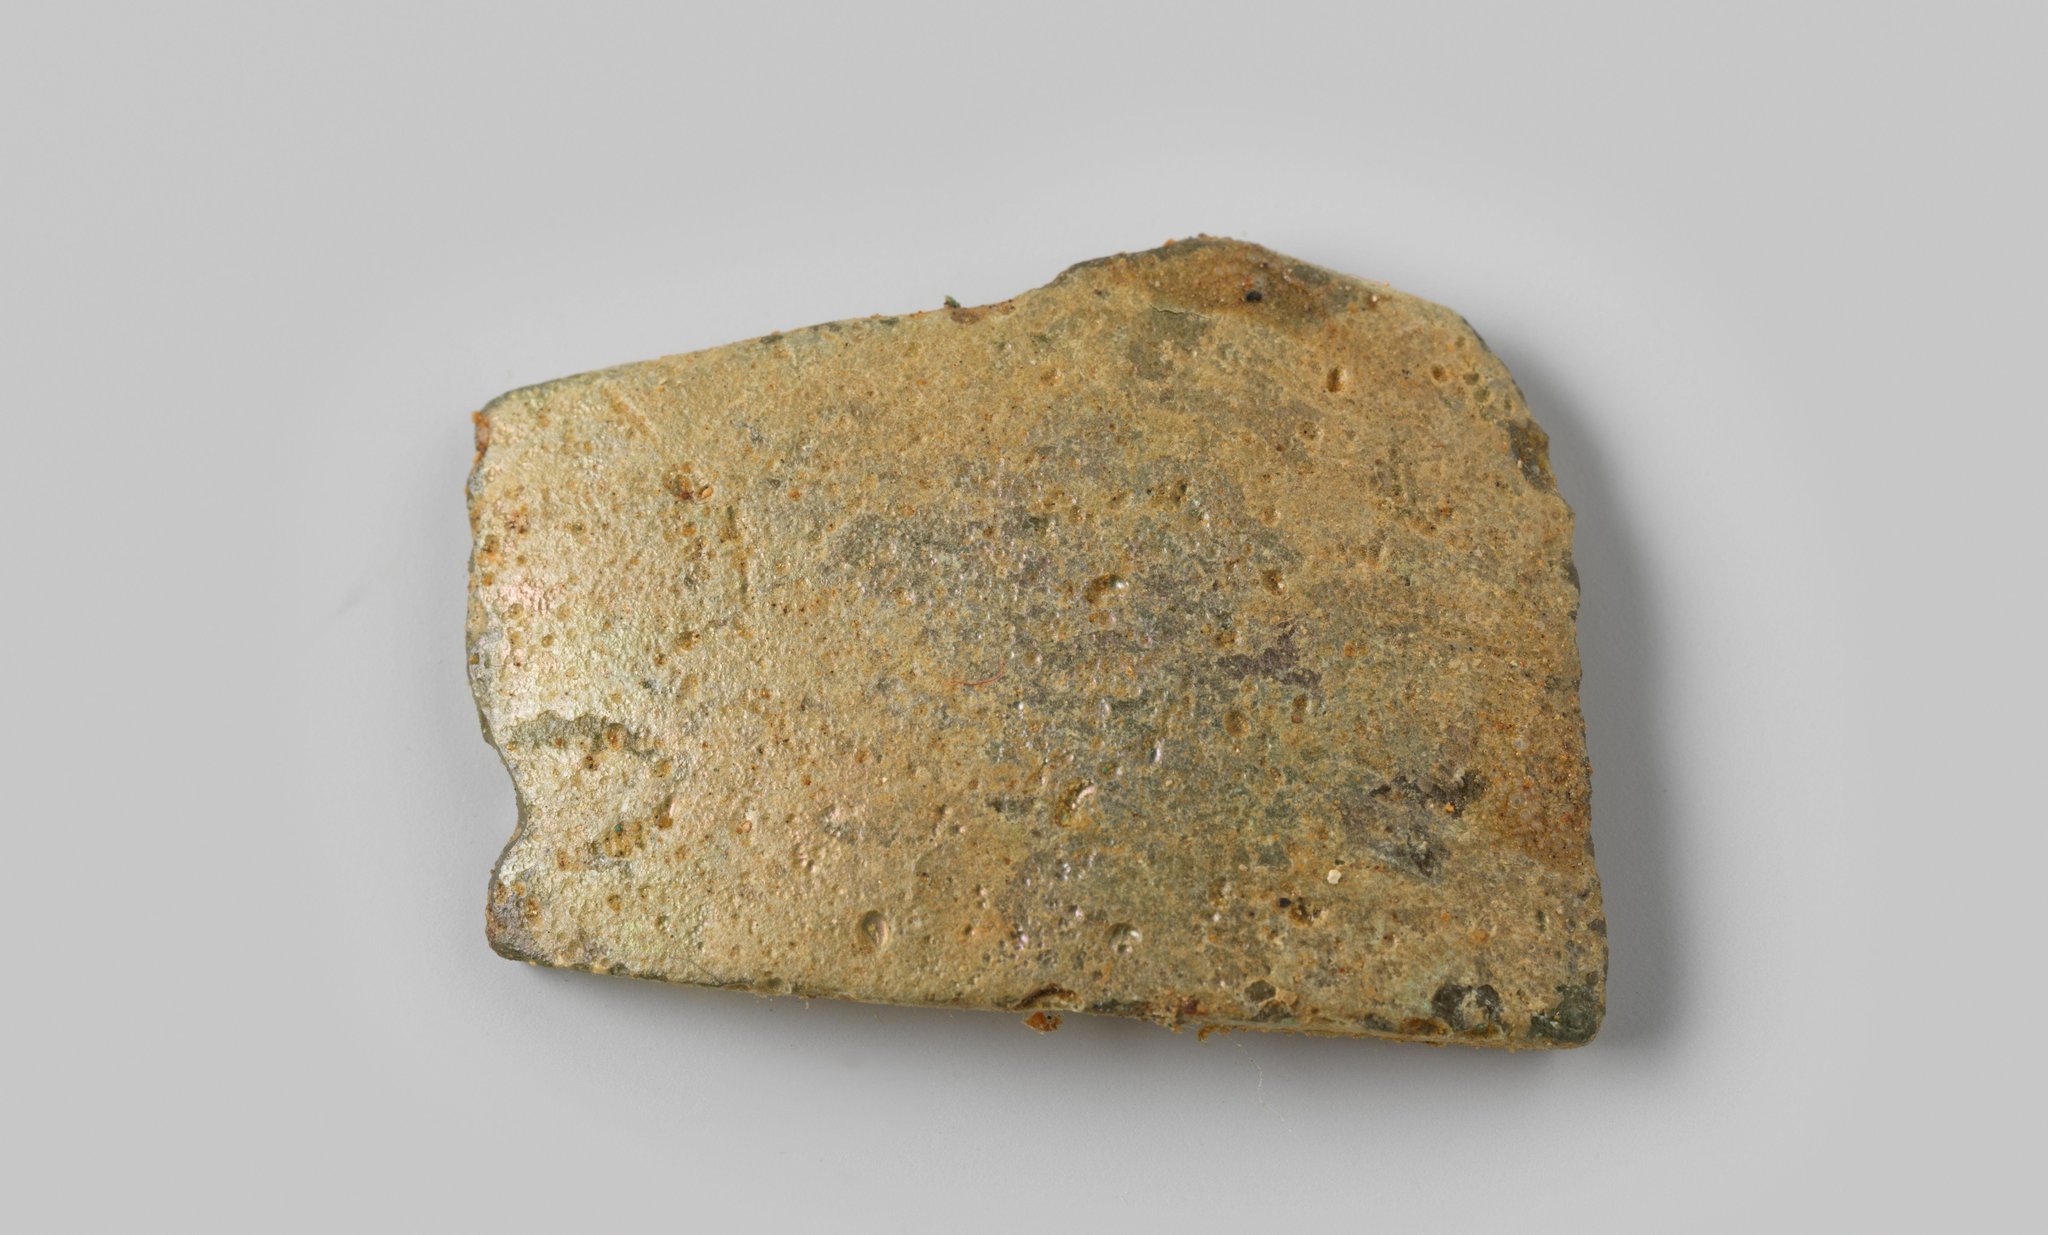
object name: wine bottle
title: Scherf van een wijnfles uit het wrak van de Oost-Indiëvaarder Hollandia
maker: Anonymous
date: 1700-1743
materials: glass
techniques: green glass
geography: netherlands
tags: verenigde oostindische compagnie, hollandia (schip), annet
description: Typologically not identifiable, belly, fragment.